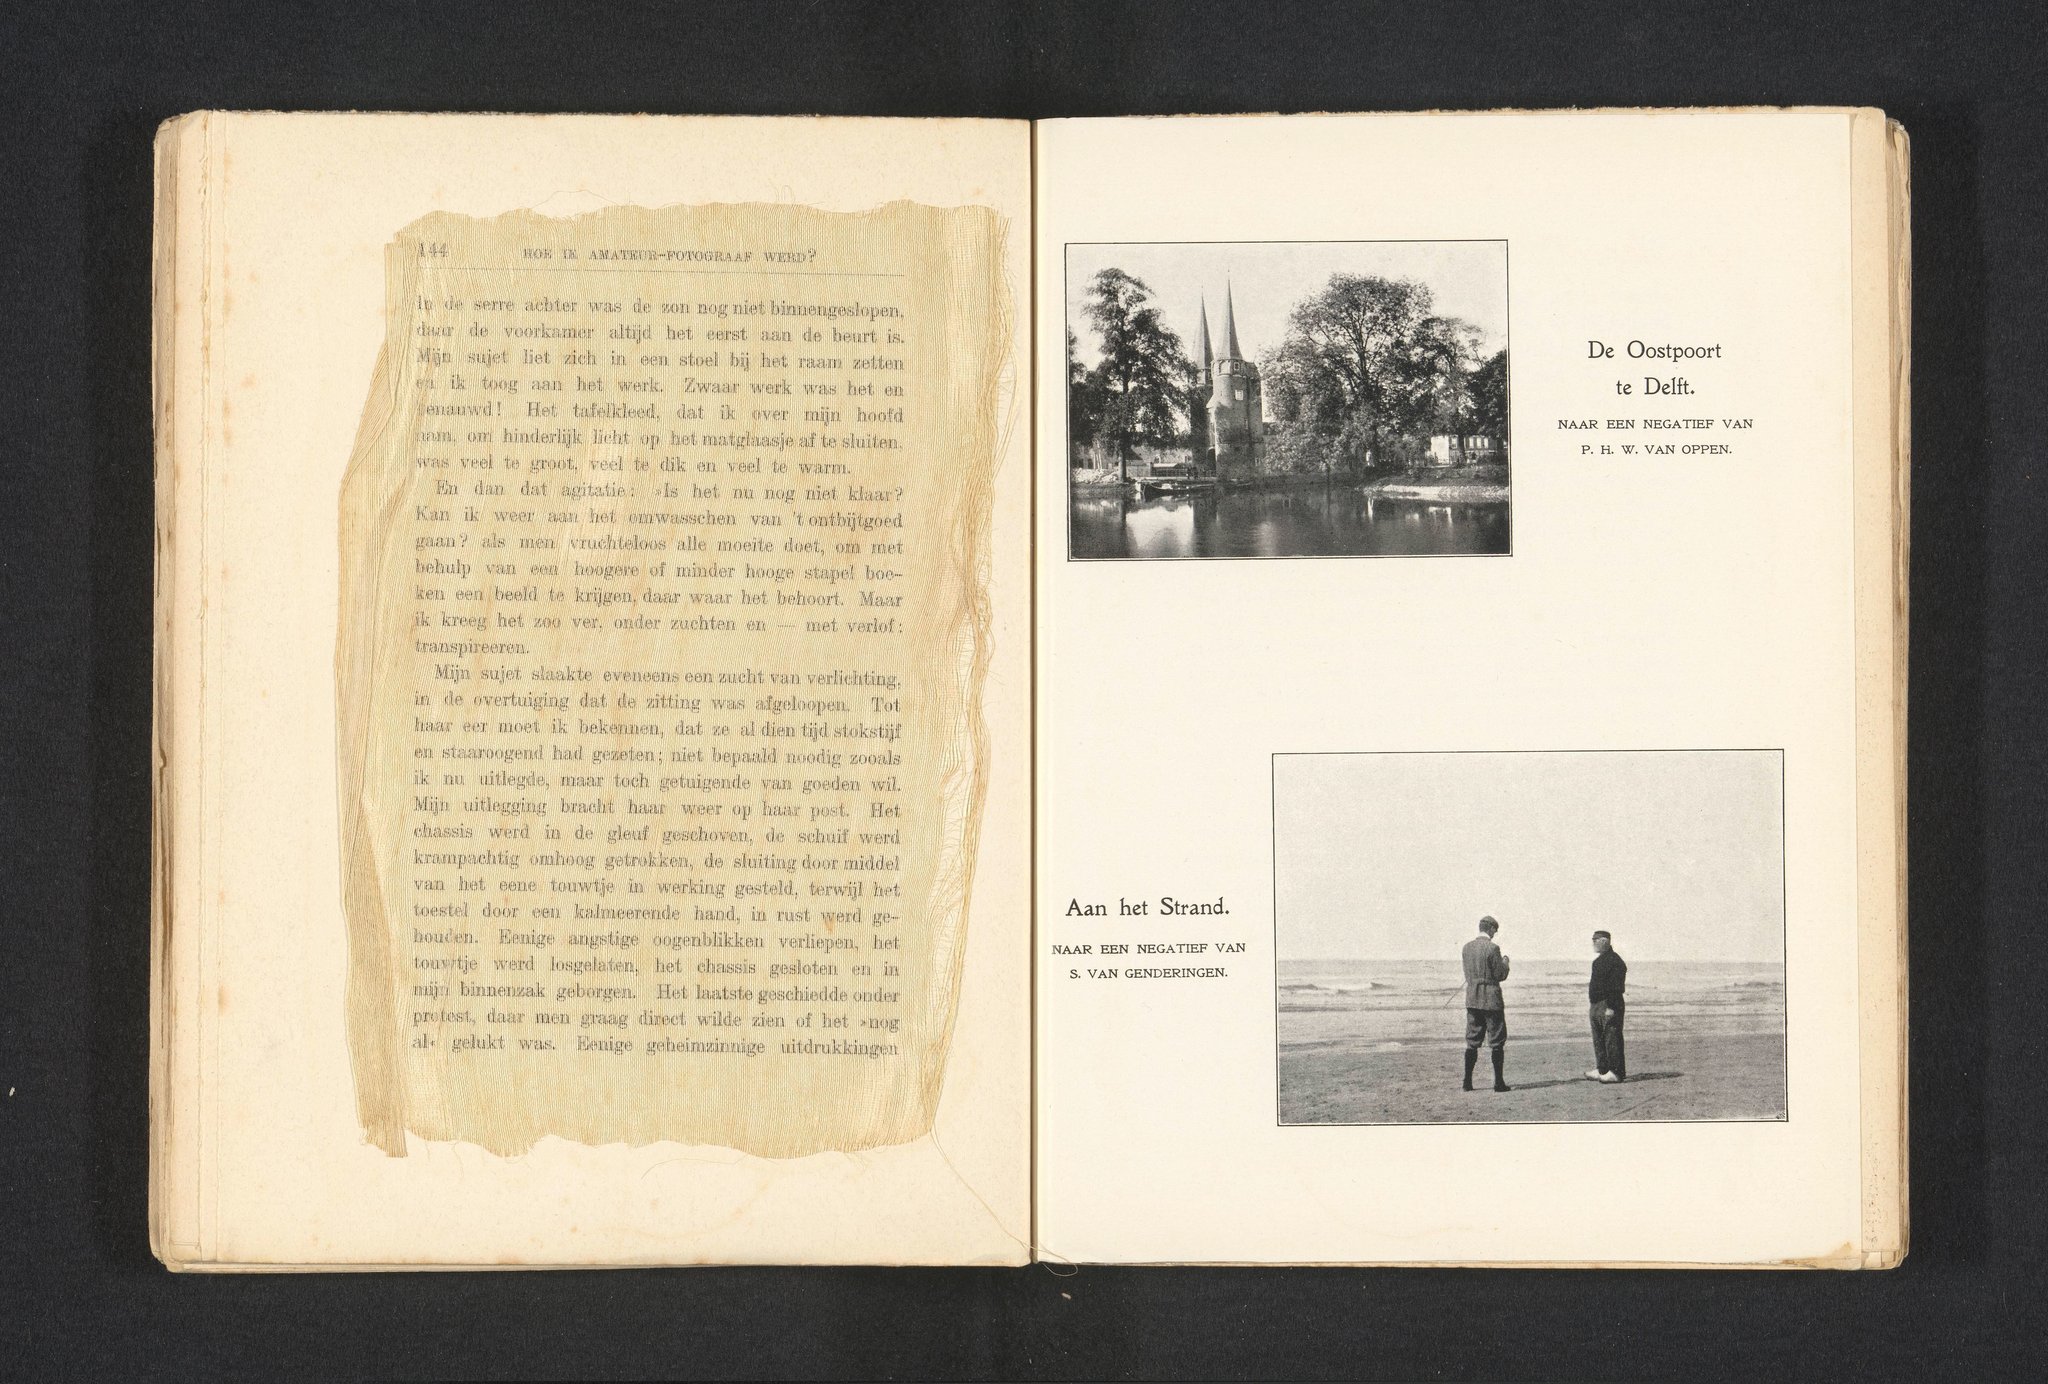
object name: page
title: De Oostpoort/ te Delft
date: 1895-1900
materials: paper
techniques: autotype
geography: delft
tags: village-gate